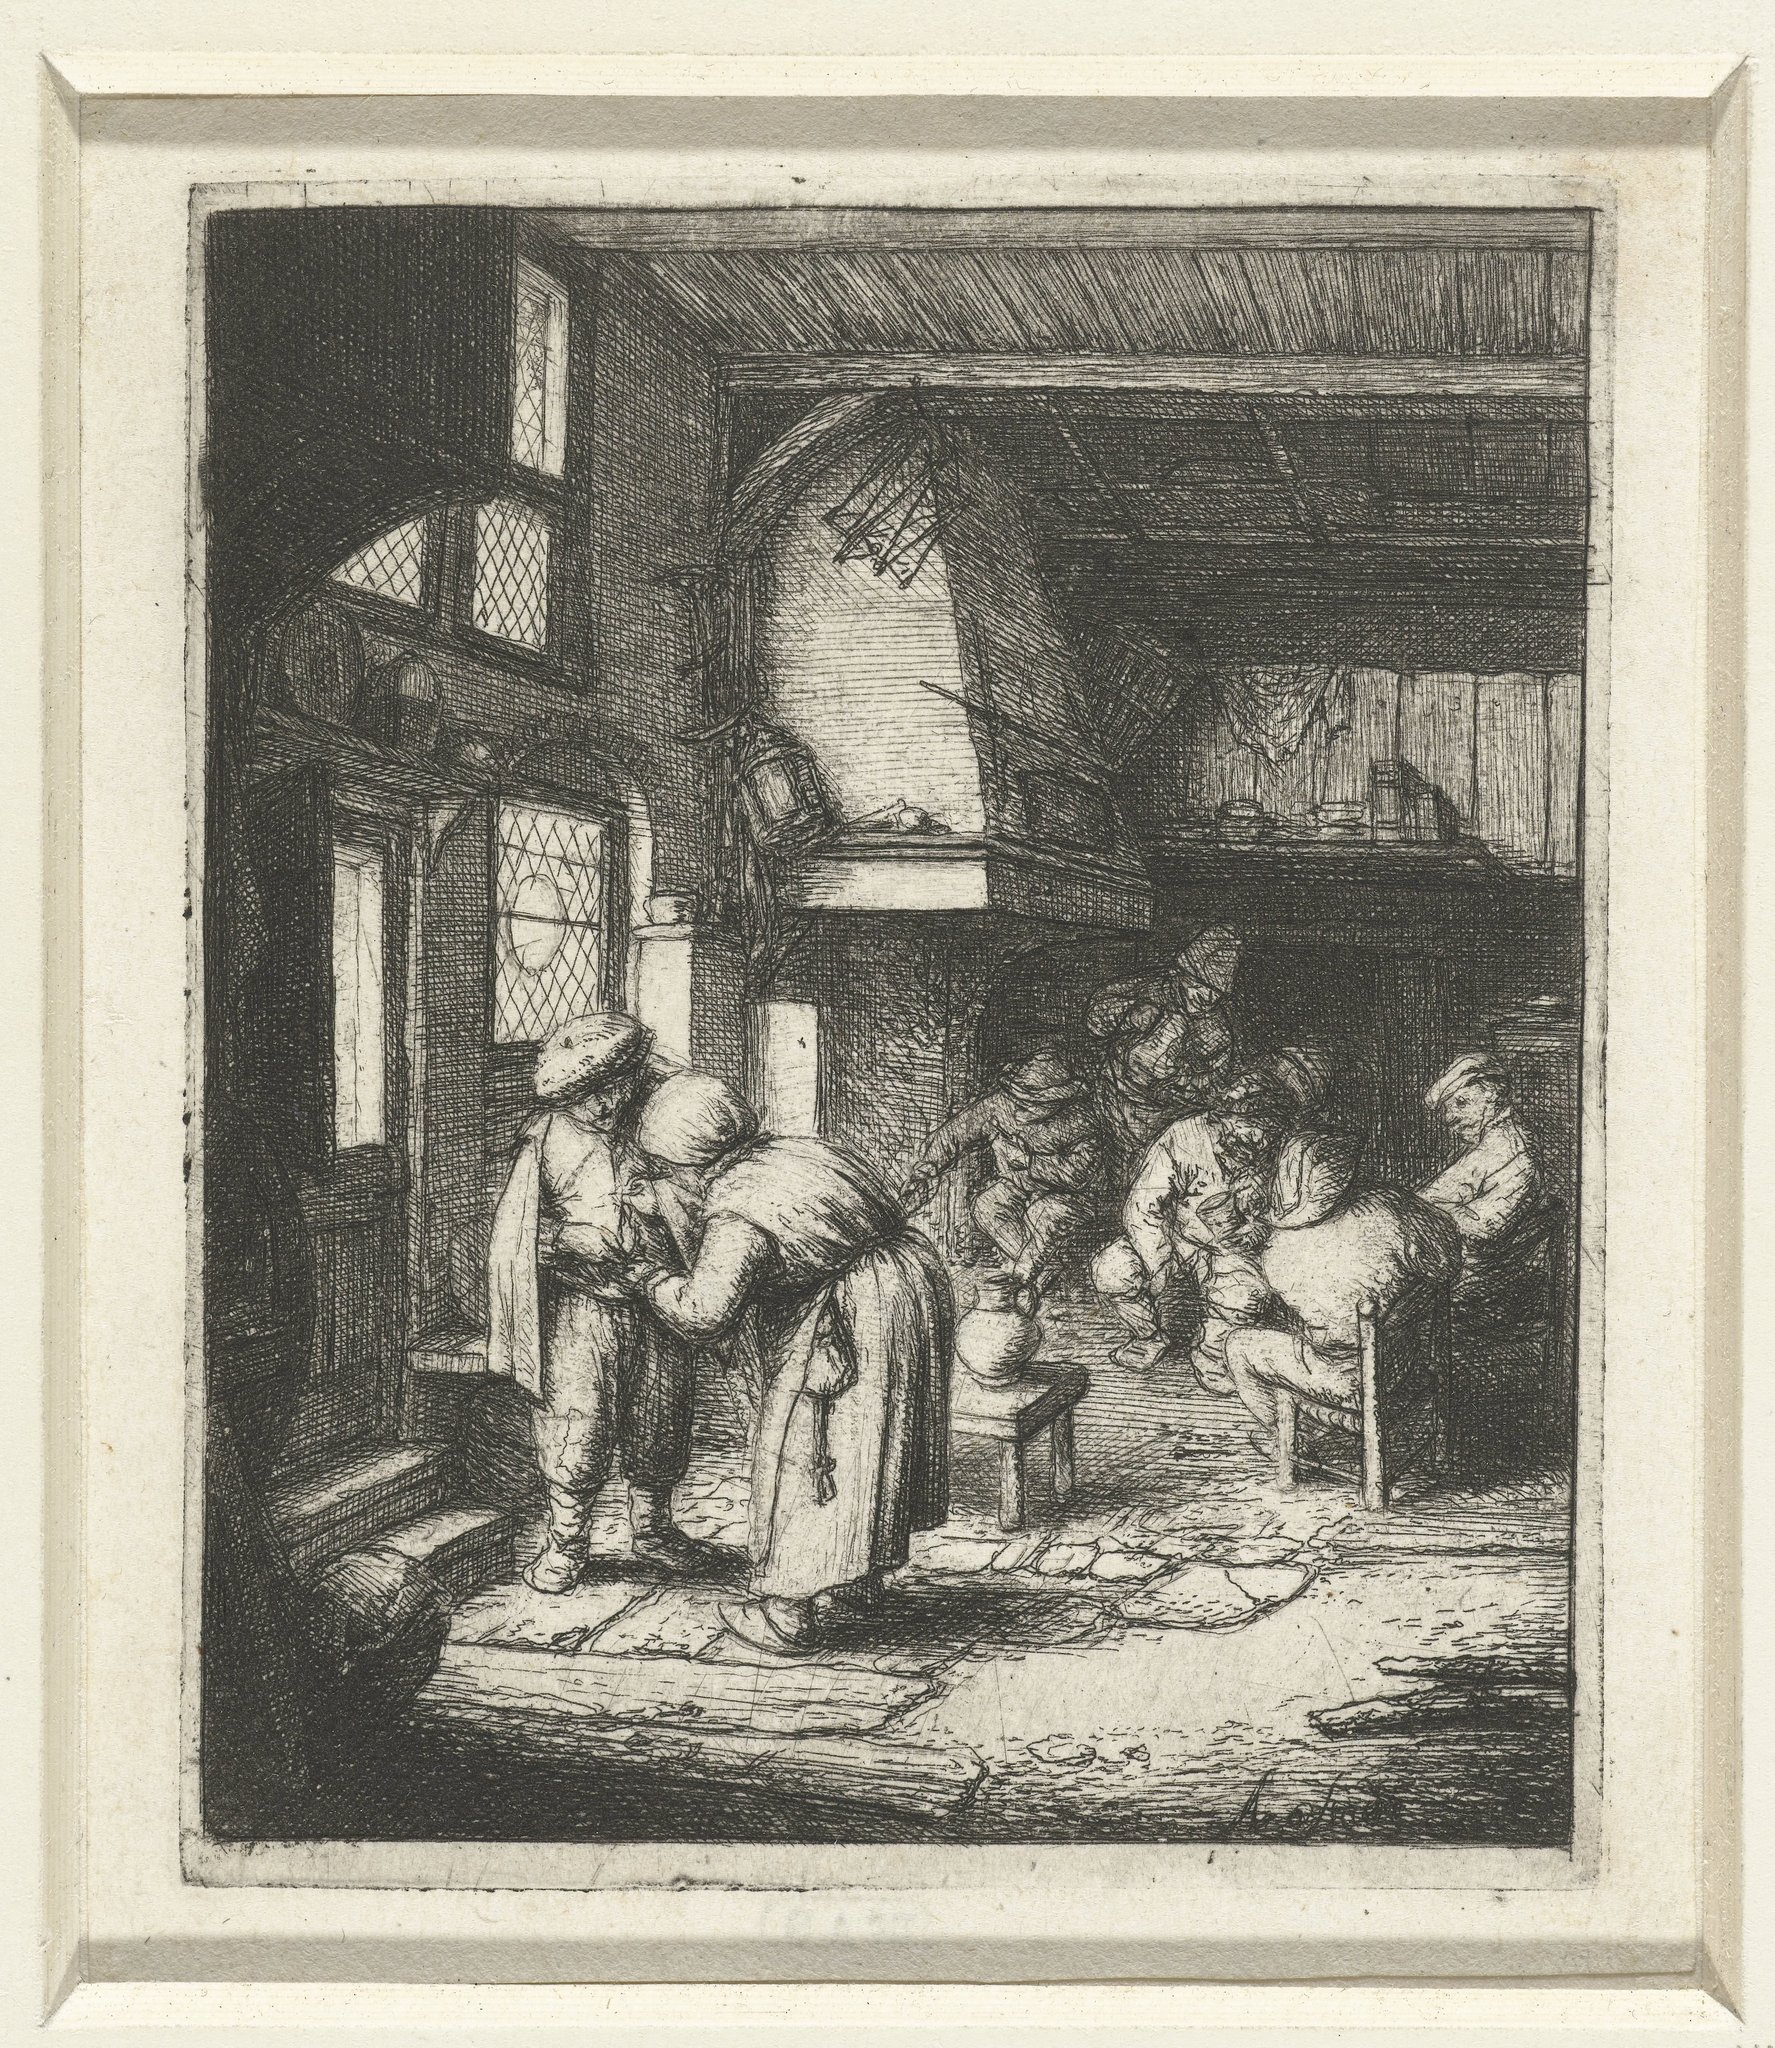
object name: print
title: De betaling van het gelag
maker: adriaen van ostade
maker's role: draughtsman, painter, print maker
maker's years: 1610-1685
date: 1647-1653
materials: paper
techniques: etching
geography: haarlem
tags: inn, coffee-house, public house, etc., indoor recreation (+ paying, settling the bill ~ indoor recreation)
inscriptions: collector's mark: Lugt 2659a, collector's mark: Lugt 787, collector's mark: Lugt 2228a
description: Interieur van een herberg met een boer die zijn gemaakte kosten afrekend met een vrouw. Door de ramen en een half geopende deur valt licht naar binnen ook op een groep mannen bij de haard achter in het vertrek.